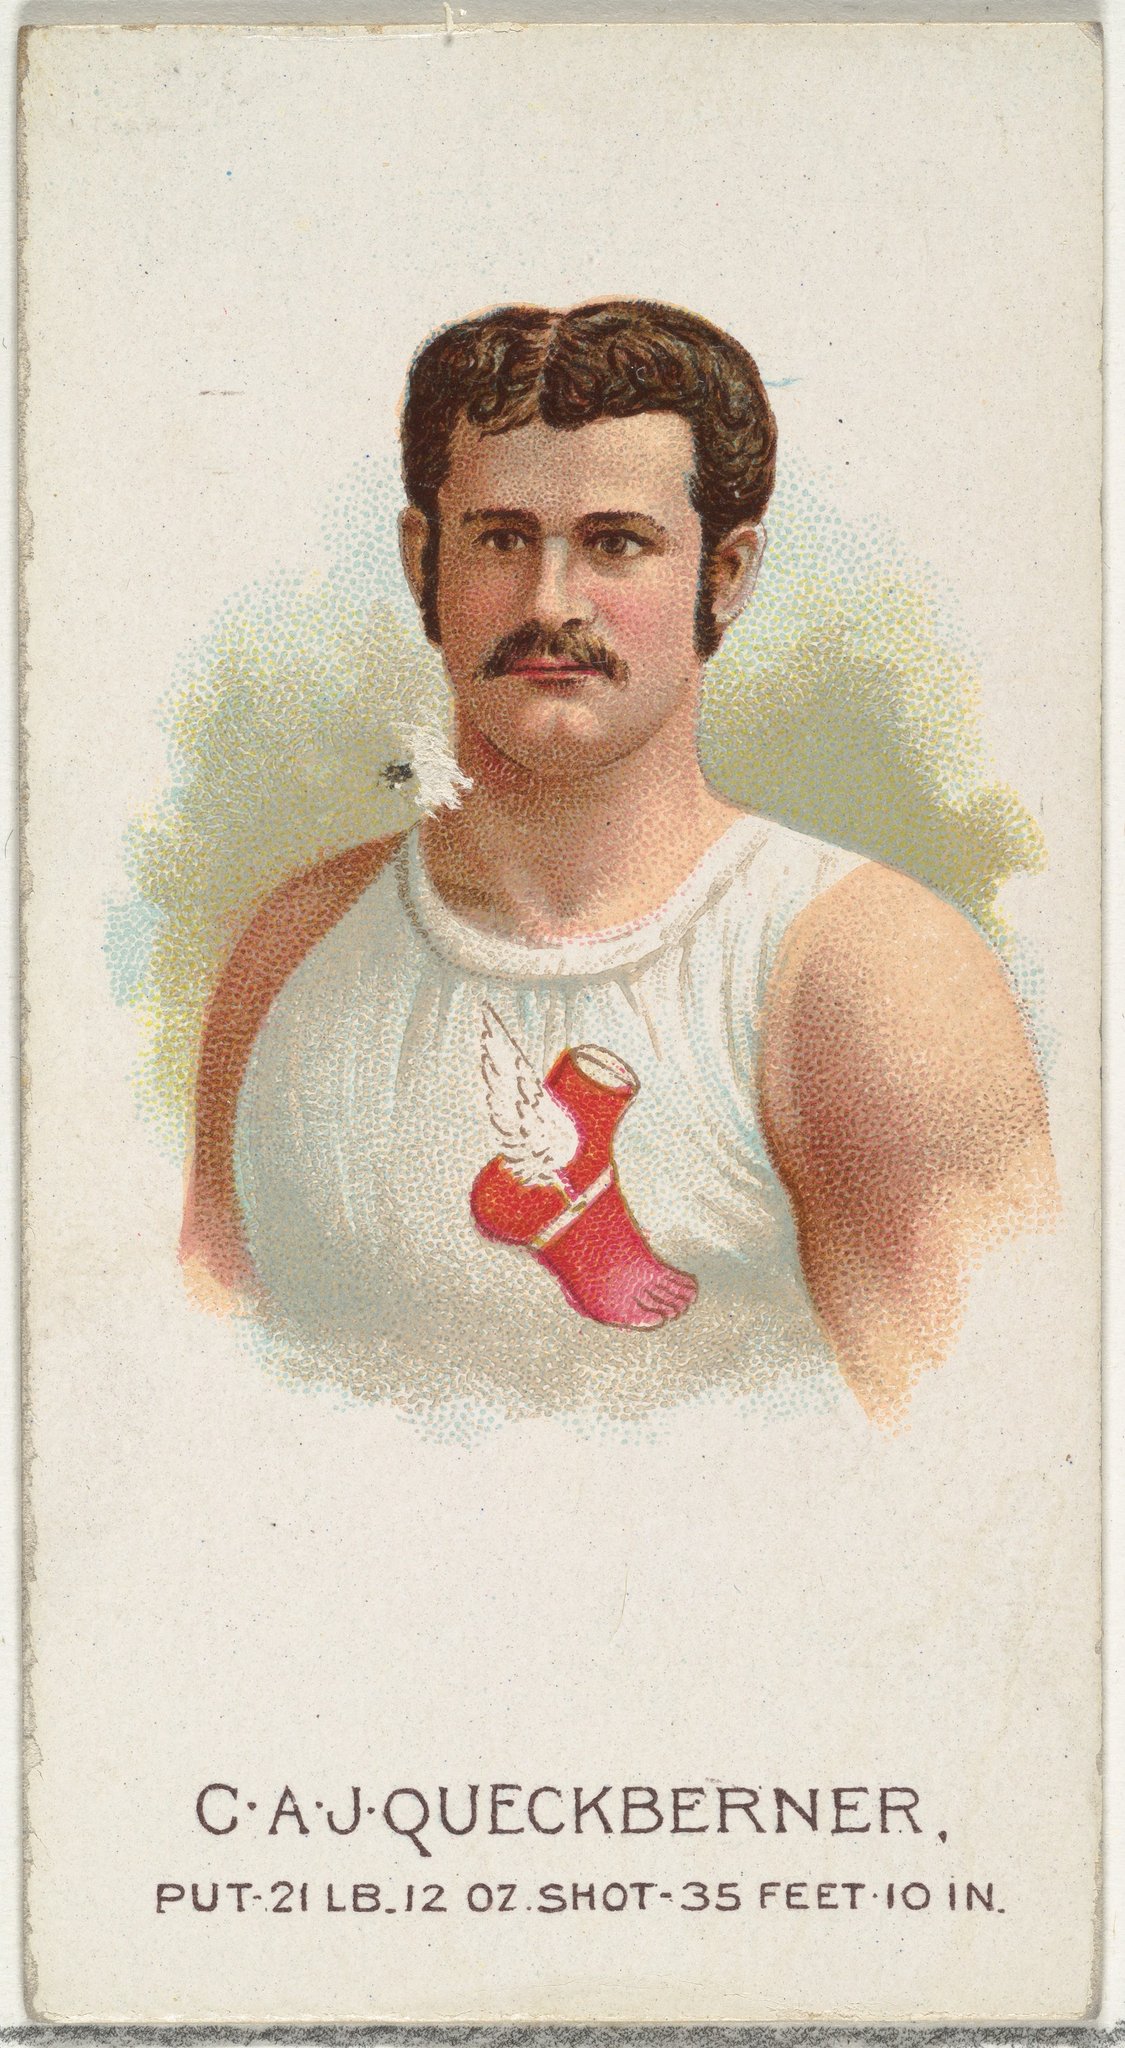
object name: print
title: C.A.J. Queckberner, Shot Put, from World's Champions, Series 2 (N29) for Allen & Ginter Cigarettes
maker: allen & ginter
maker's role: publisher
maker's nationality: american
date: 1888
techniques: color lithograph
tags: men,portraits,athletes